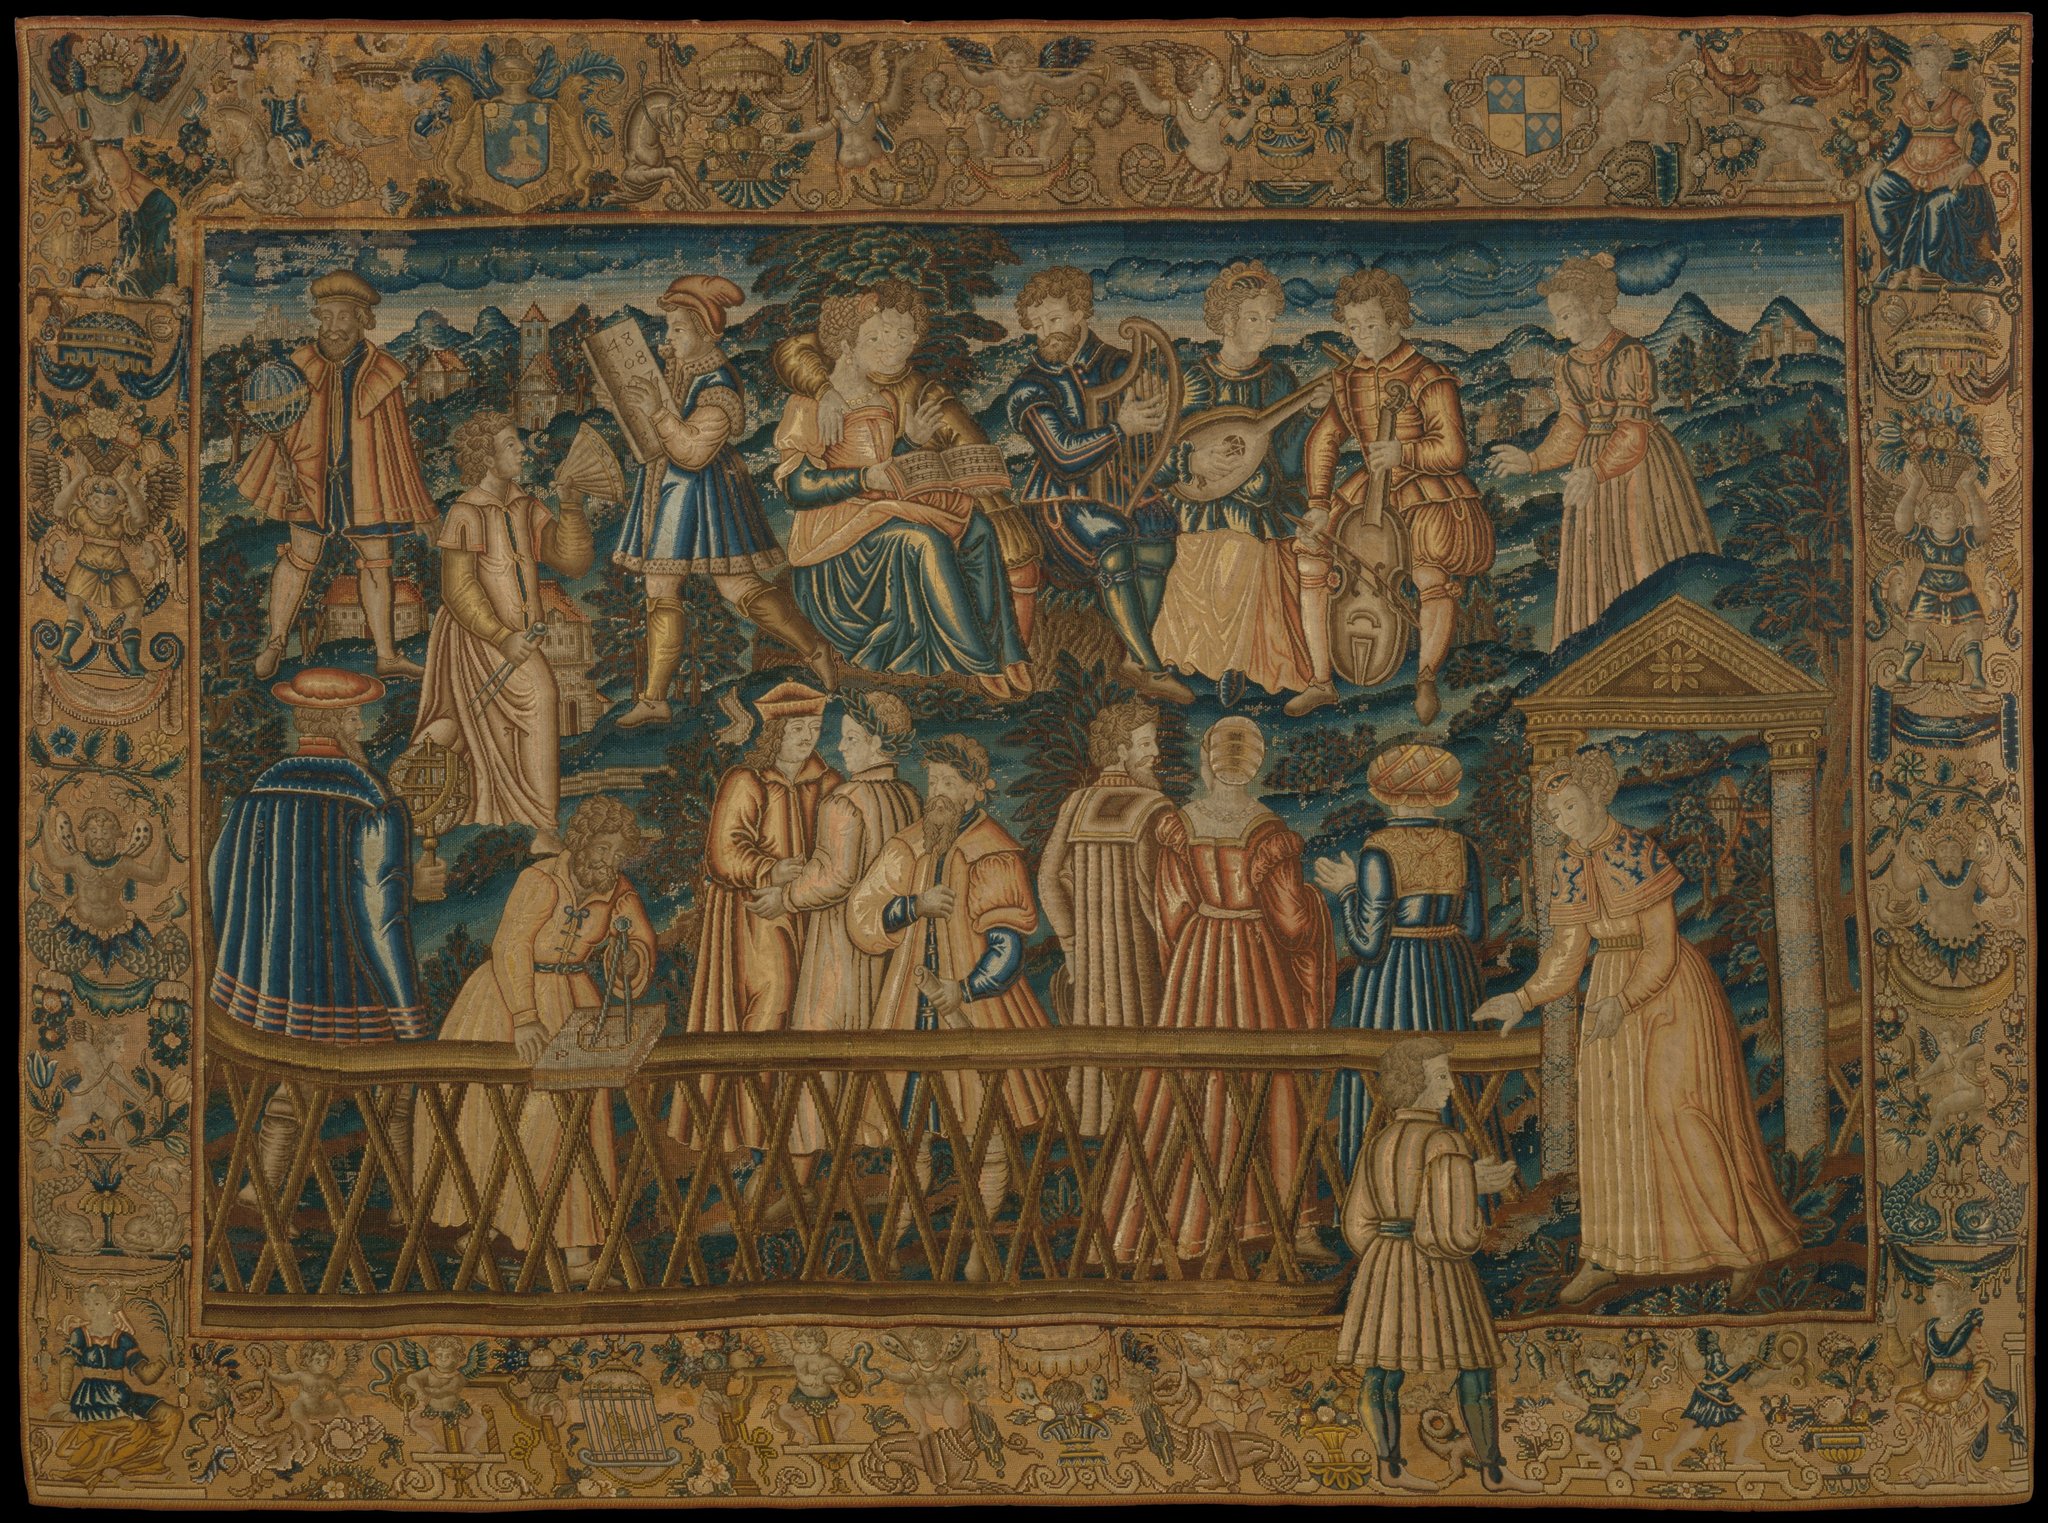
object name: hanging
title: The Garden of False Learning from The Table of Cebes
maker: david kandel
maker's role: designer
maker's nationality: german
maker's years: 1515-1601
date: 1550-1580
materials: canvas, silk, wool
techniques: stitching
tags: musical instruments,gardens,men,women,globes